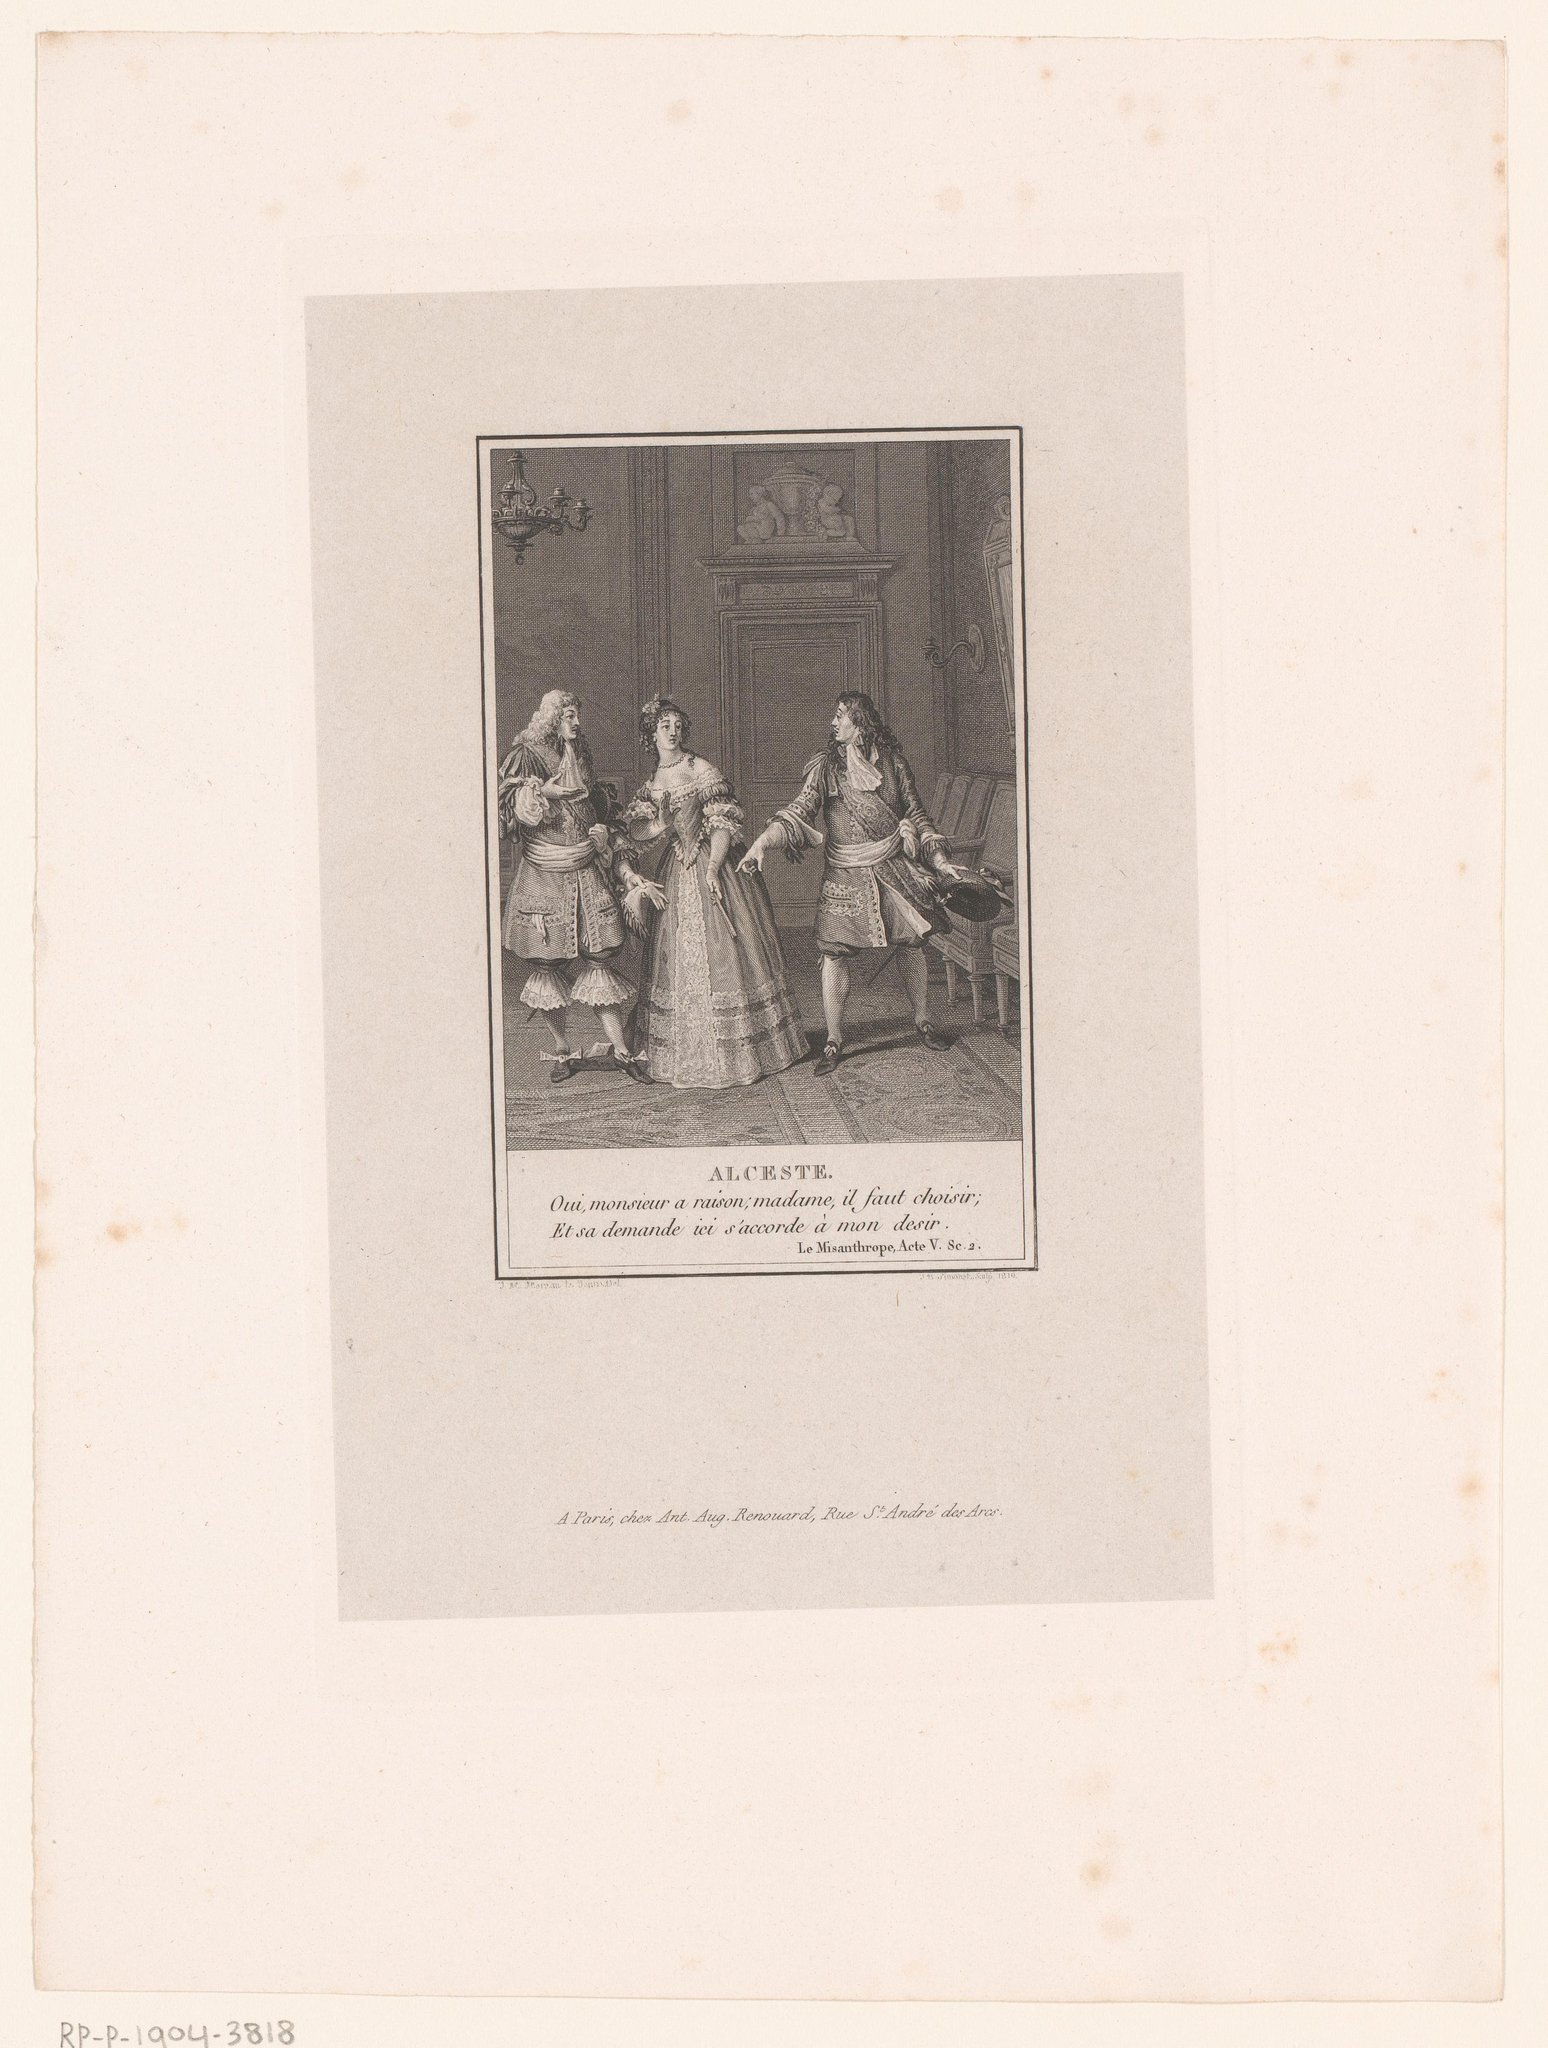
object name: book illustration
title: Interieur met vrouw tussen twee mannen in, haar hand opgeheven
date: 1811-1813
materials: paper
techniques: engraving, etching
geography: paris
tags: comedy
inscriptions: collector's mark: Lugt 2228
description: Prent van scène twee van de vijfde acte uit 'Le Misanthrope' door Jean Baptiste Molière. Dit betreft één van de dertig prenten, gemaakt in opdracht van Antoine Augustin Renouard, bestemd voor verschillende edities van Molières werk daterend van 1811 tot 1813. De prenten zijn vervaardigd door verschillende kunstenaars naar composities van Moreau.